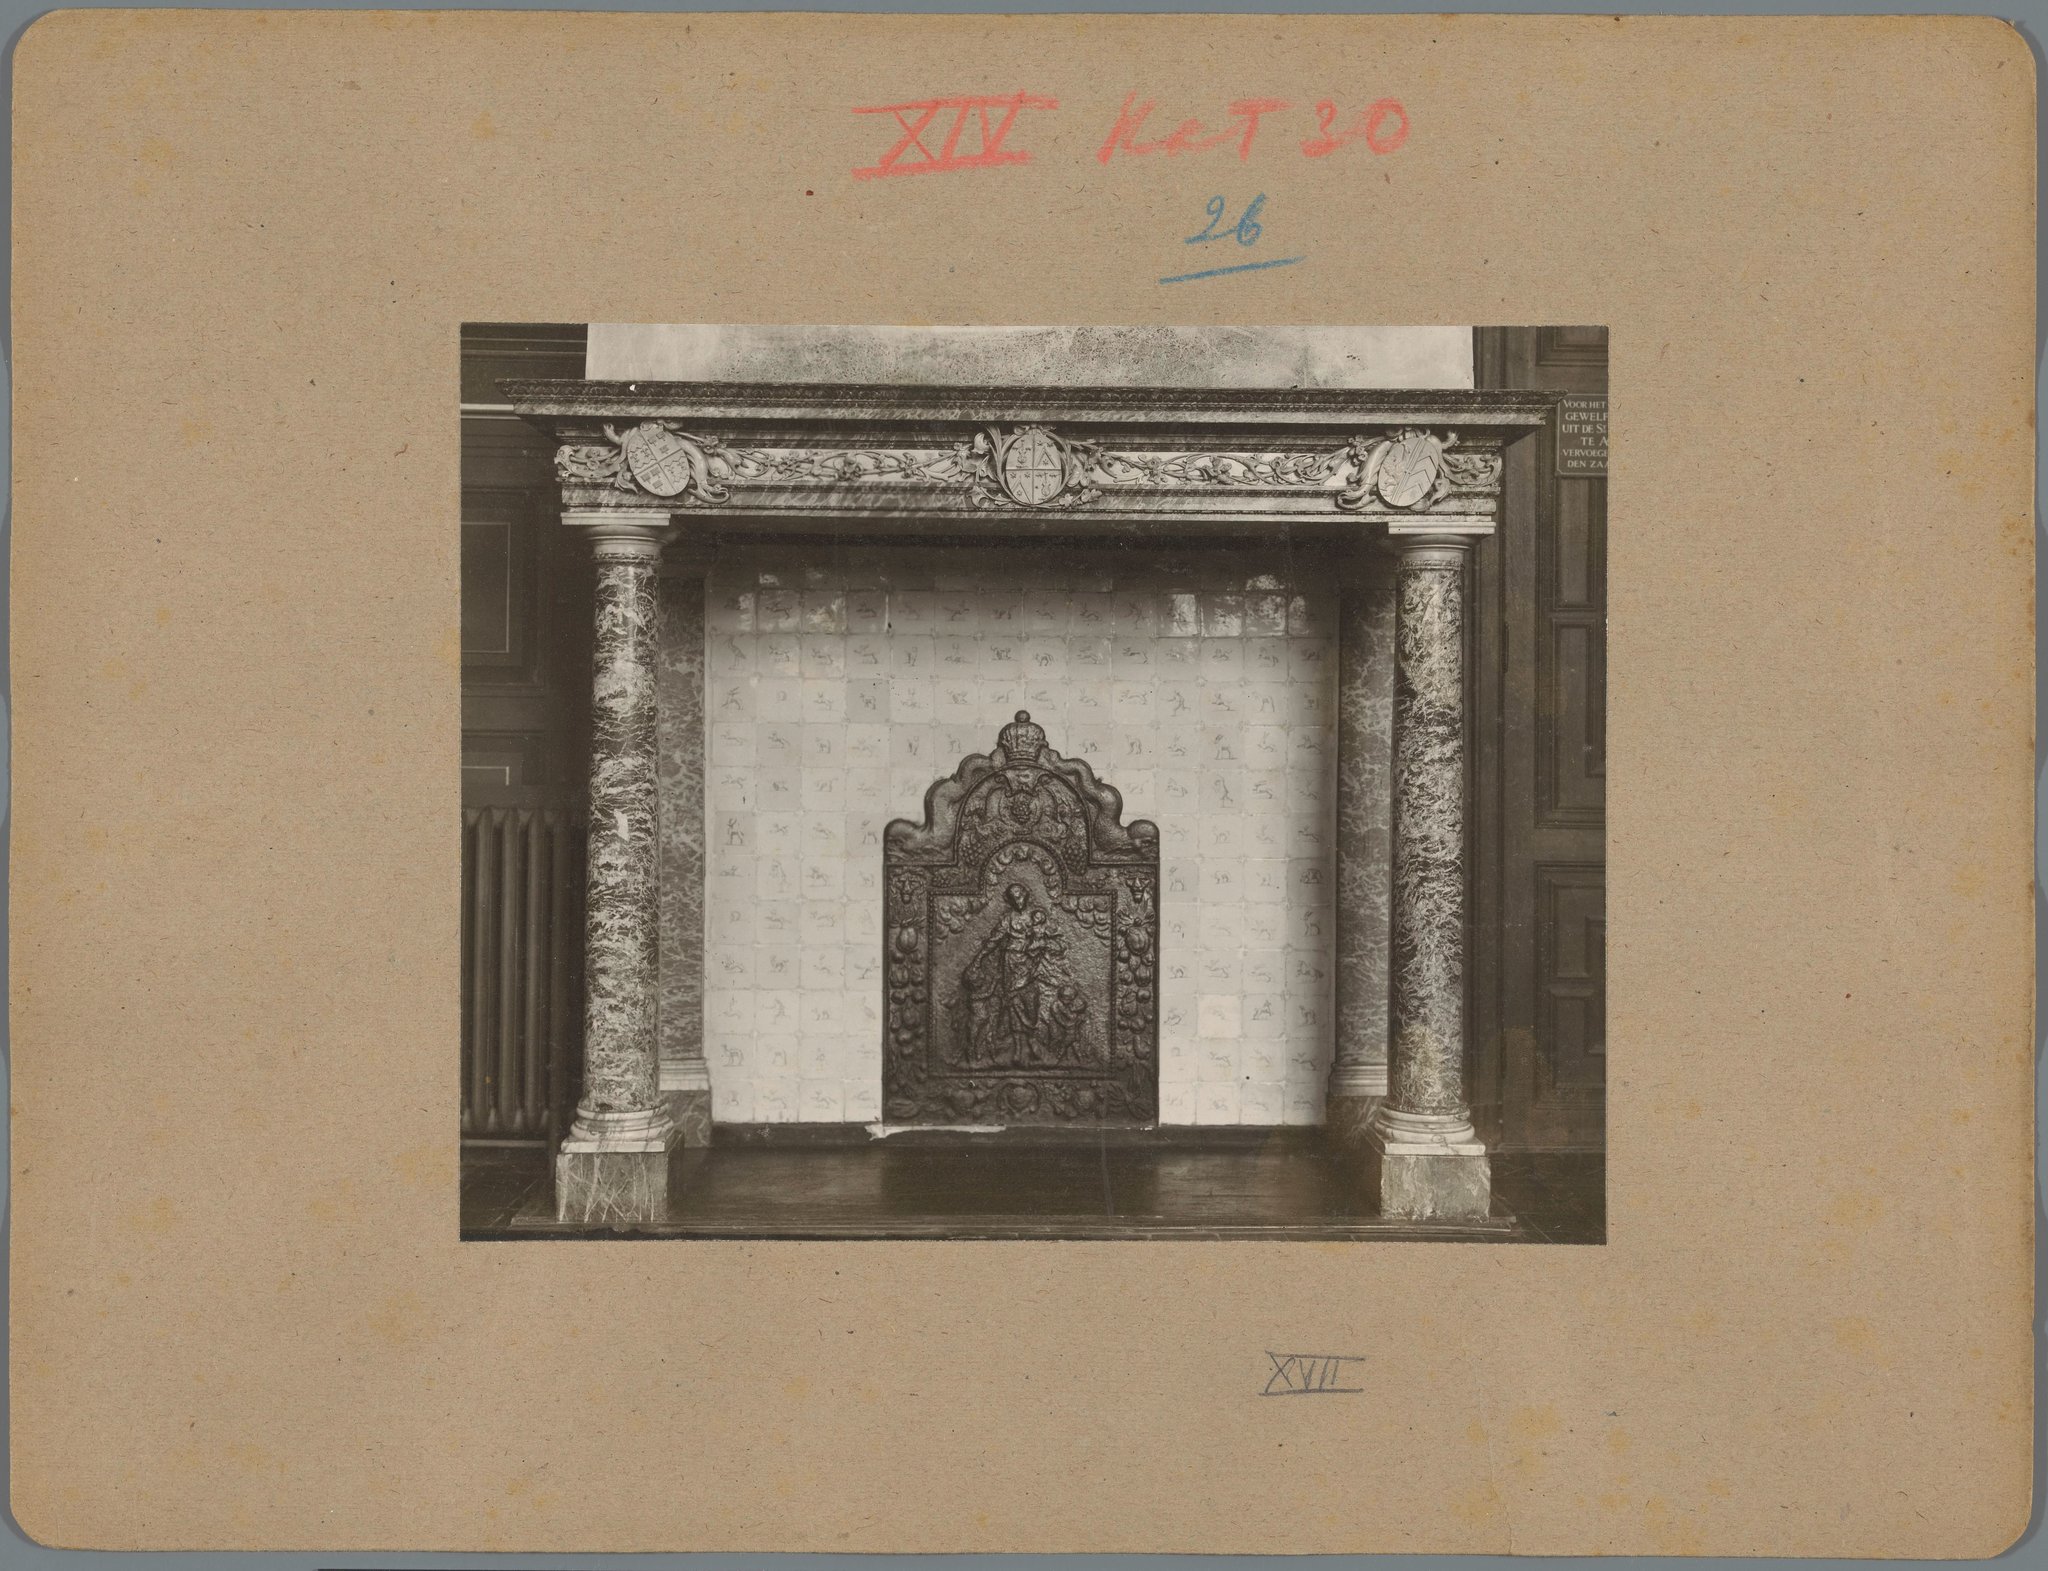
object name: photograph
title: Schouw met een haardplaat met een reliëf van de deugd Caritas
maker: Anonymous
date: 1875-1900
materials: cardboard, photographic support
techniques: gelatin silver print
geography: europe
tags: charity, 'caritas'; 'carità' (ripa) ~ one of the three theological virtues, hearth-plate, open hearth, fire-place, europe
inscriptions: number: ‘Kat 30’, number: ‘26’, collector's mark: ‘INSTITUUT VOOR KUNST-NIJVERHEIDSONDERWIJS GABRIËL METSUSTRAAT No. 16 AMSTERDAM’, number: ‘XIV’, number: ‘XVII’, collector's mark: ‘KUNSTNIJVERHEIDSCHOOL QUELLINUS AMSTERDAM FRANS HALSSTRAAT 14.’